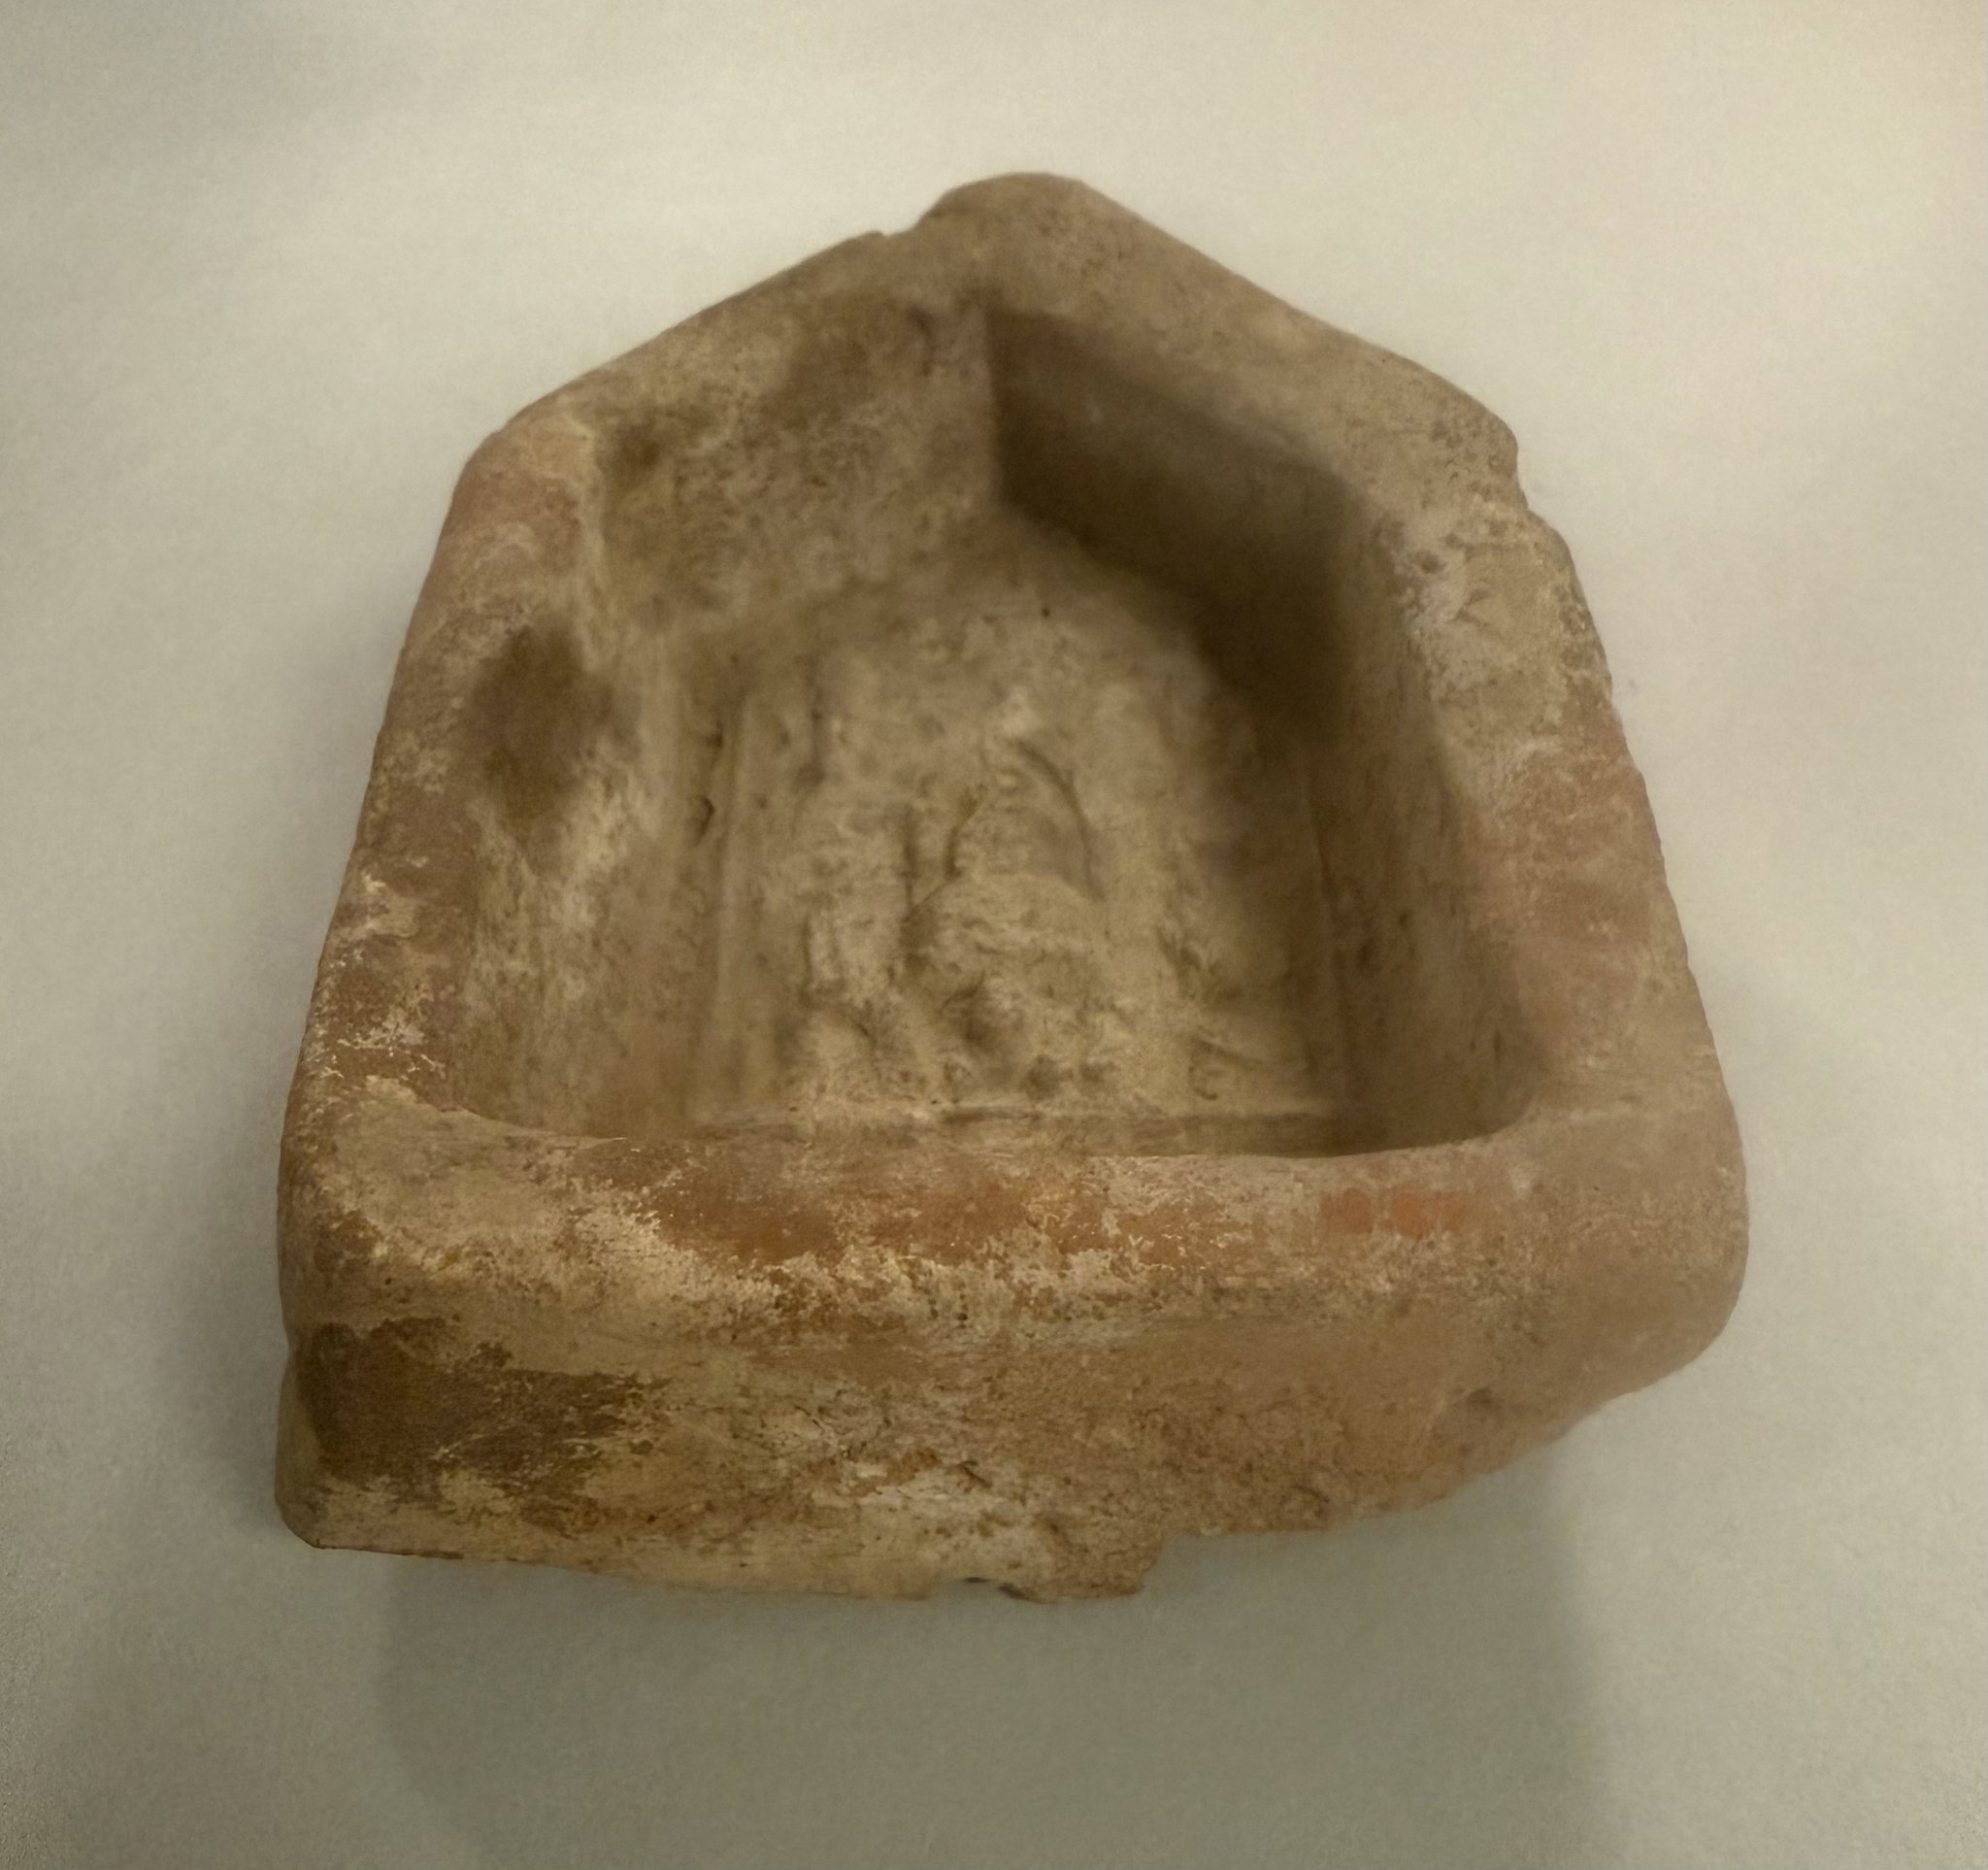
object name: shrine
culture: burmese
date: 801-1000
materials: pottery